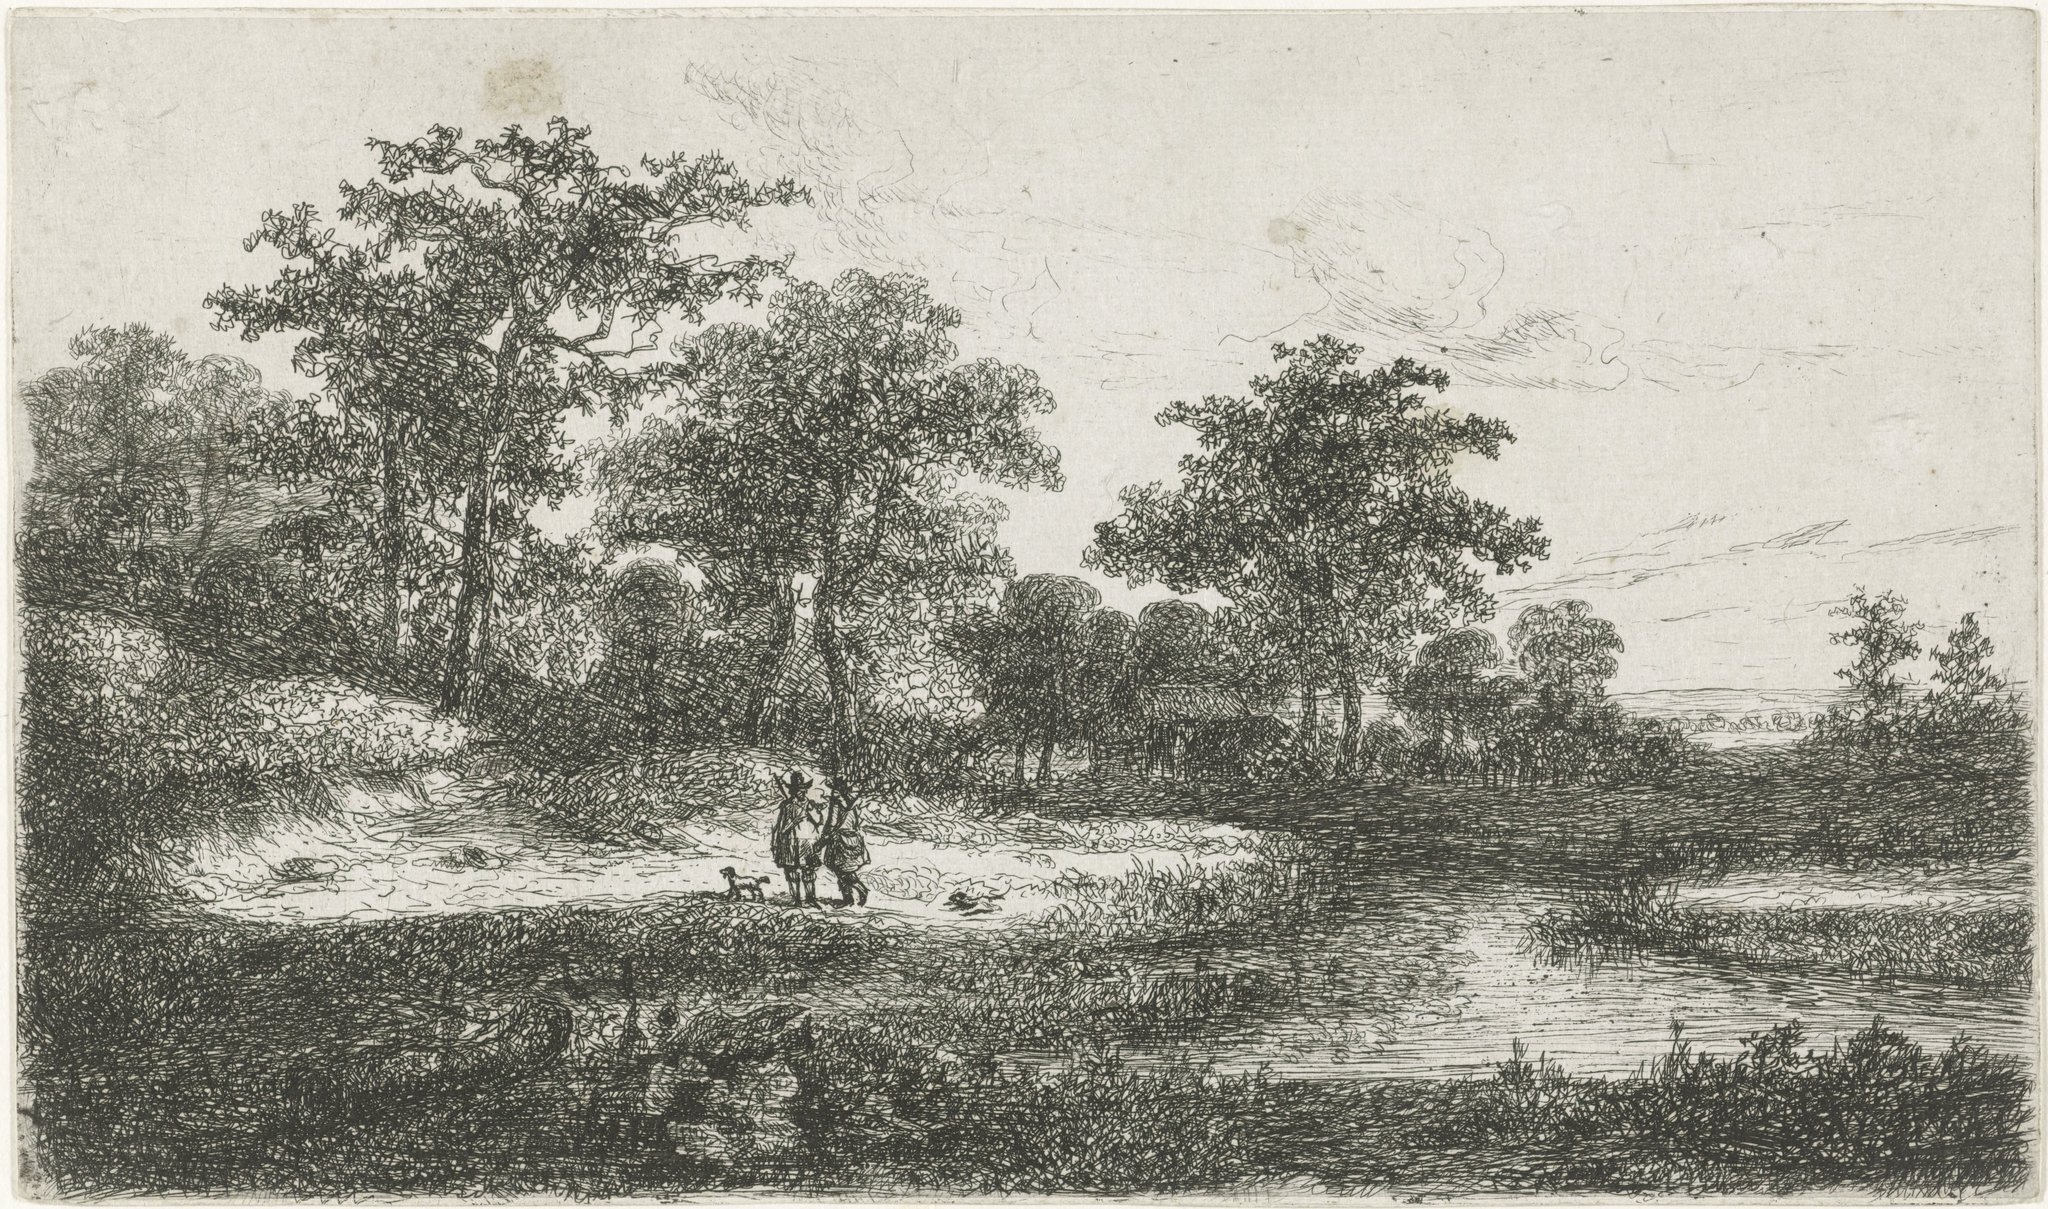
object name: print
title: Twee jagers bij een ven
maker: hermanus jan hendrik van rijkelijkhuysen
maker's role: painter, print maker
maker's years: 1813-1883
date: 1857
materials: paper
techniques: drypoint, etching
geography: utrecht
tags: trees, hunter, fen, du. 'ven', dog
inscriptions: collector's mark: Lugt 2228